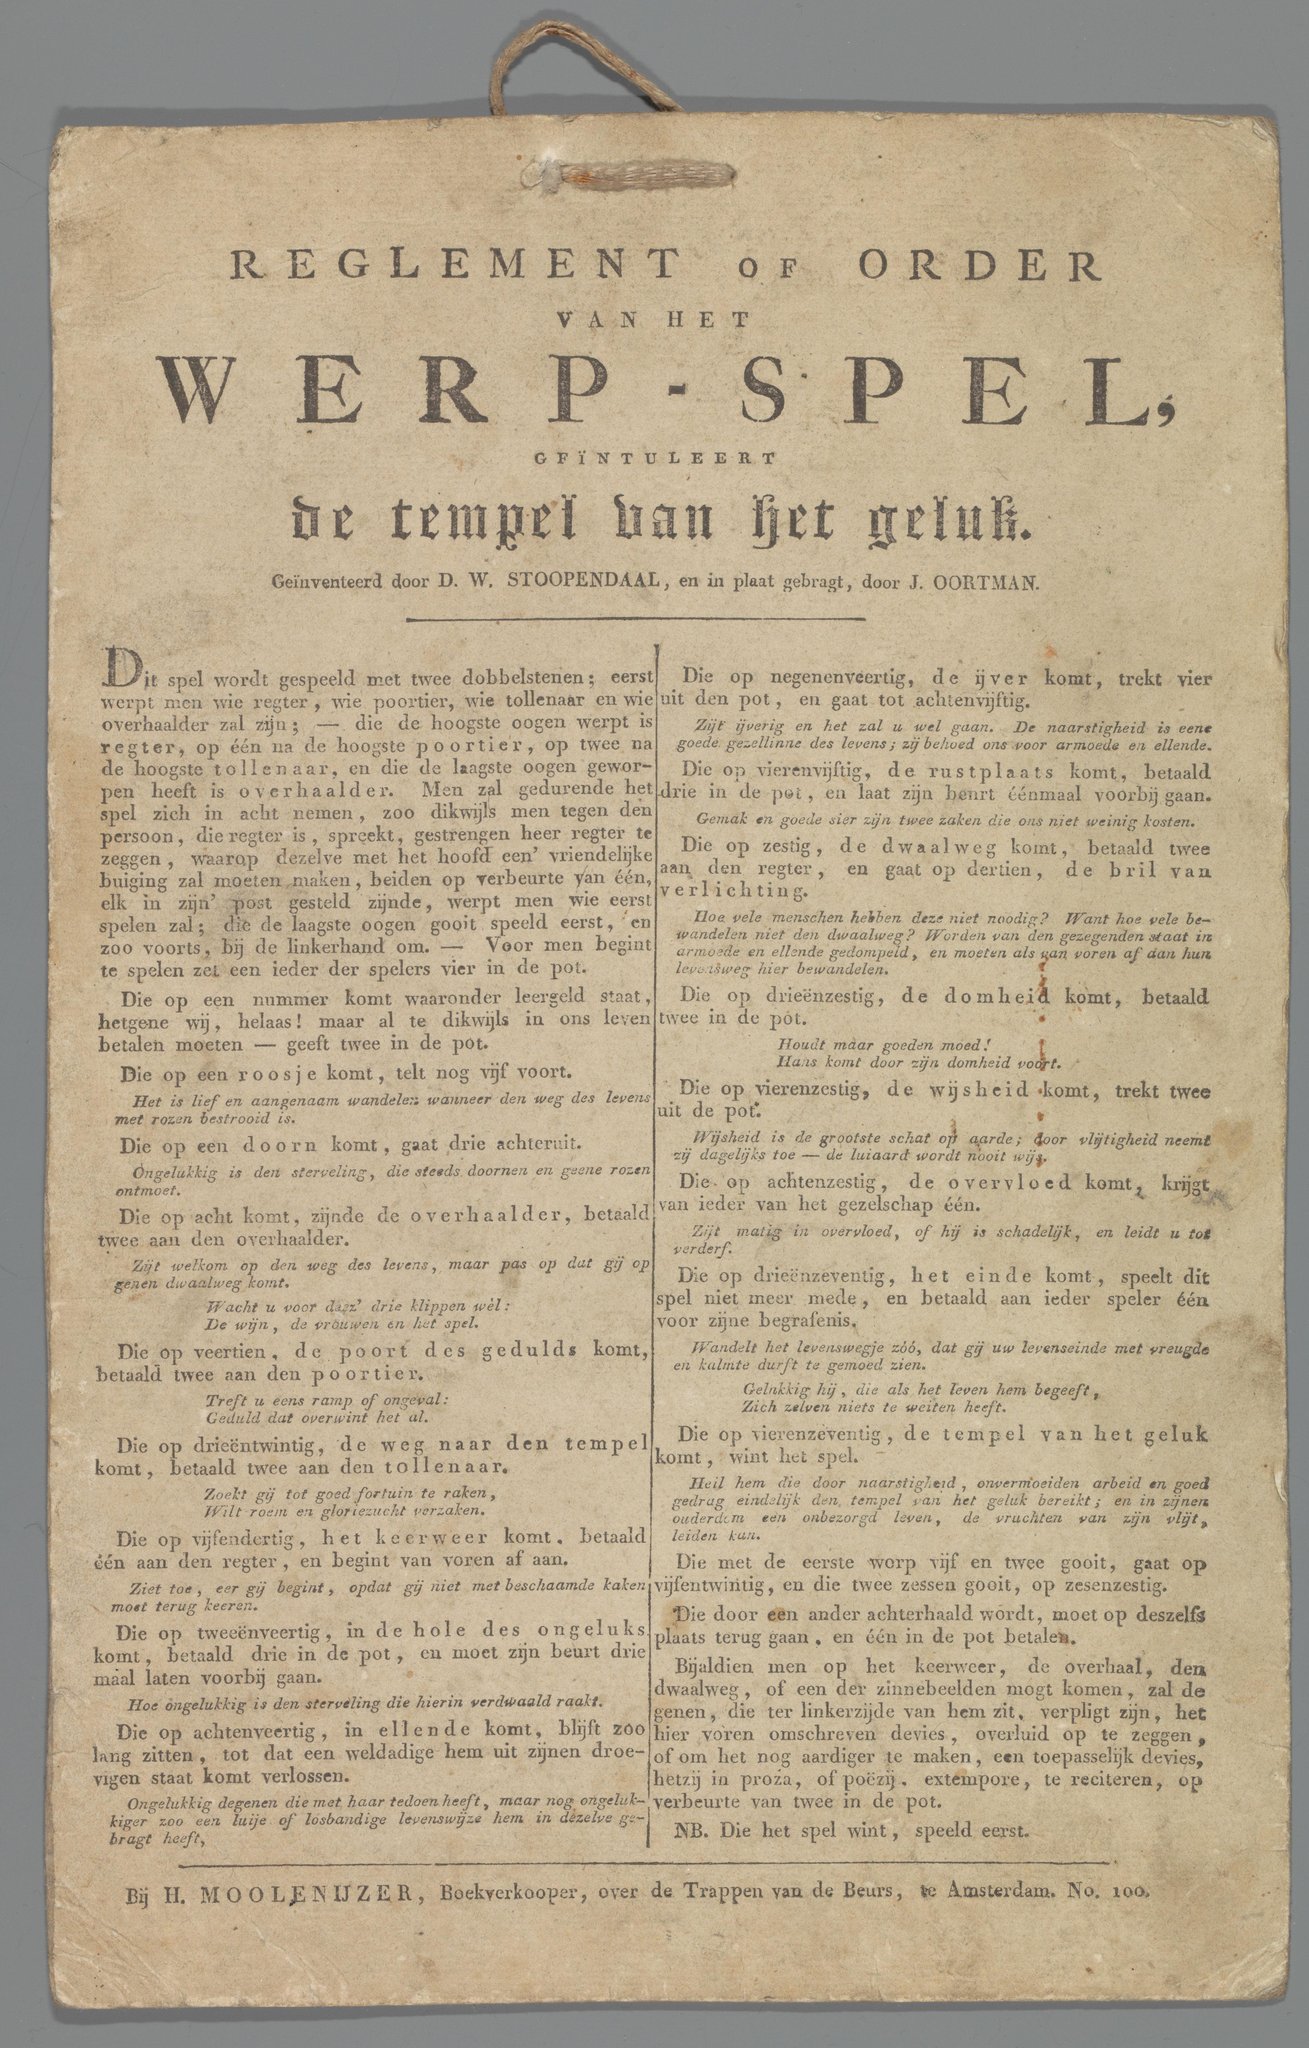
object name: text sheet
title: Spelregels bij het bordspel: Tempel van het geluk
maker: hendrik moolenyzer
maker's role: publisher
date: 1816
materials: cardboard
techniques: letterpress printing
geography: amsterdam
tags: board-games of chance, board-games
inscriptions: collector's mark: Lugt 2760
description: Spelregels bij het bordspel: Tempel van het geluk in boekdruk.